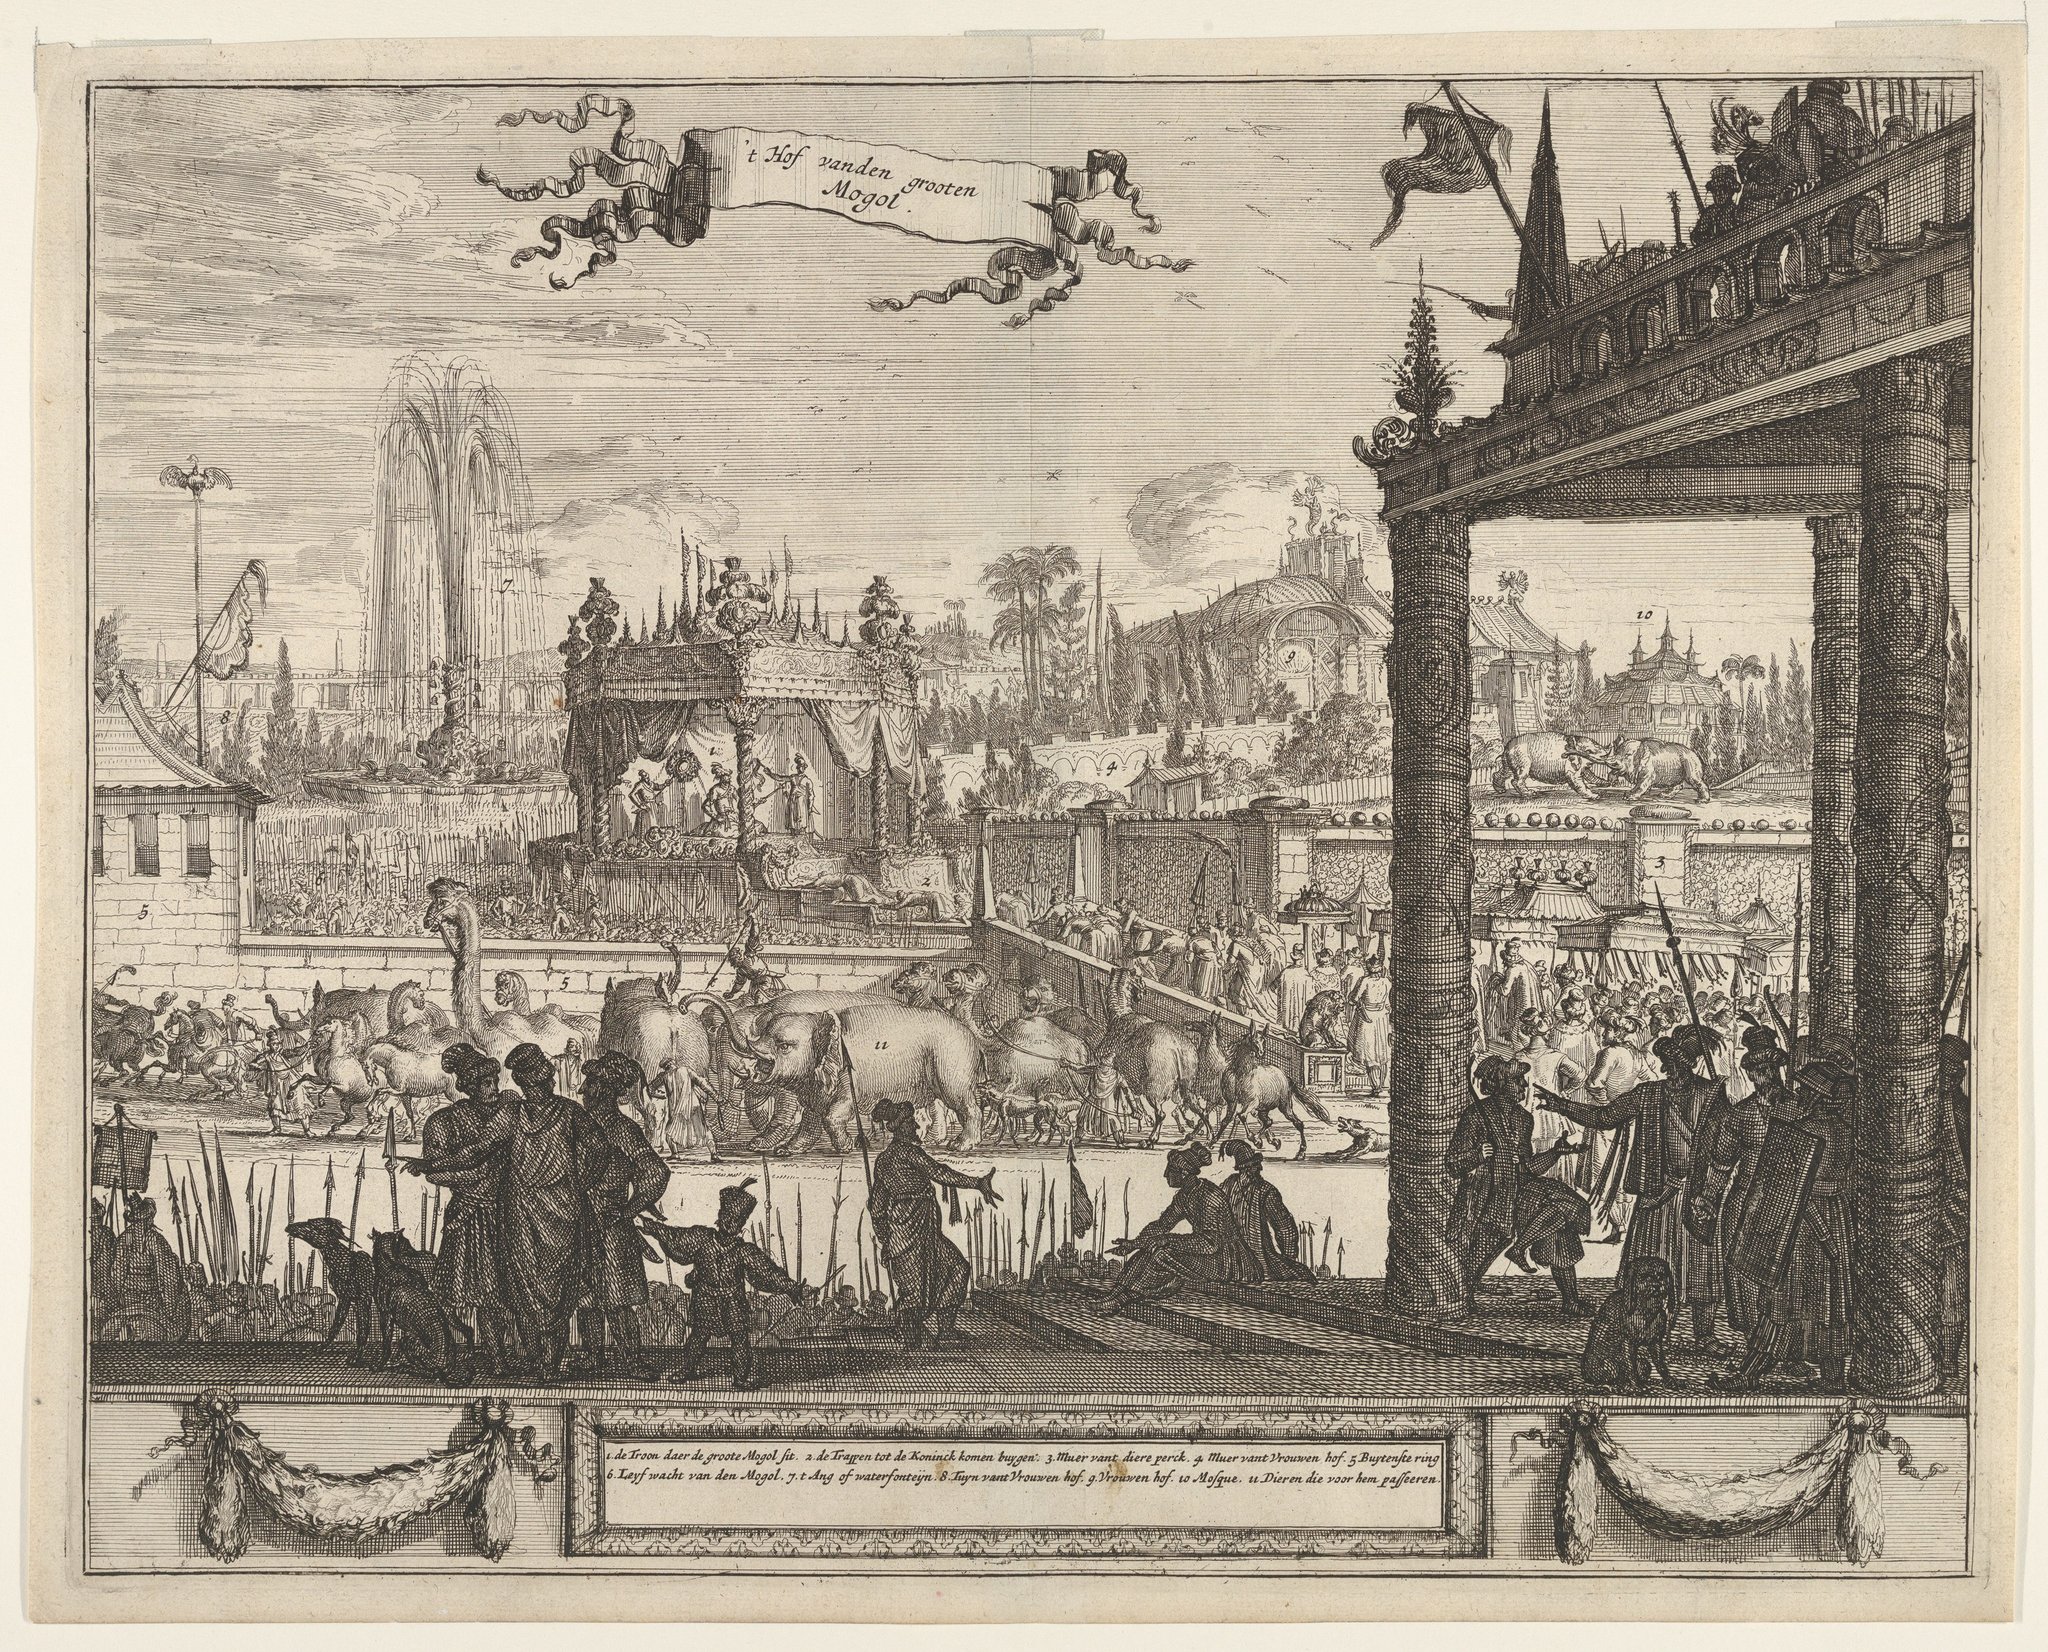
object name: print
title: The Court of the Great Mogul ('t Hof vanden grooten Mogol)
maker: anonymous, dutch, 17th century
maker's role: artist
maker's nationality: dutch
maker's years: 1600-1700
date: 1601-1700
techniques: etching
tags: animals,architecture,elephants,crowd